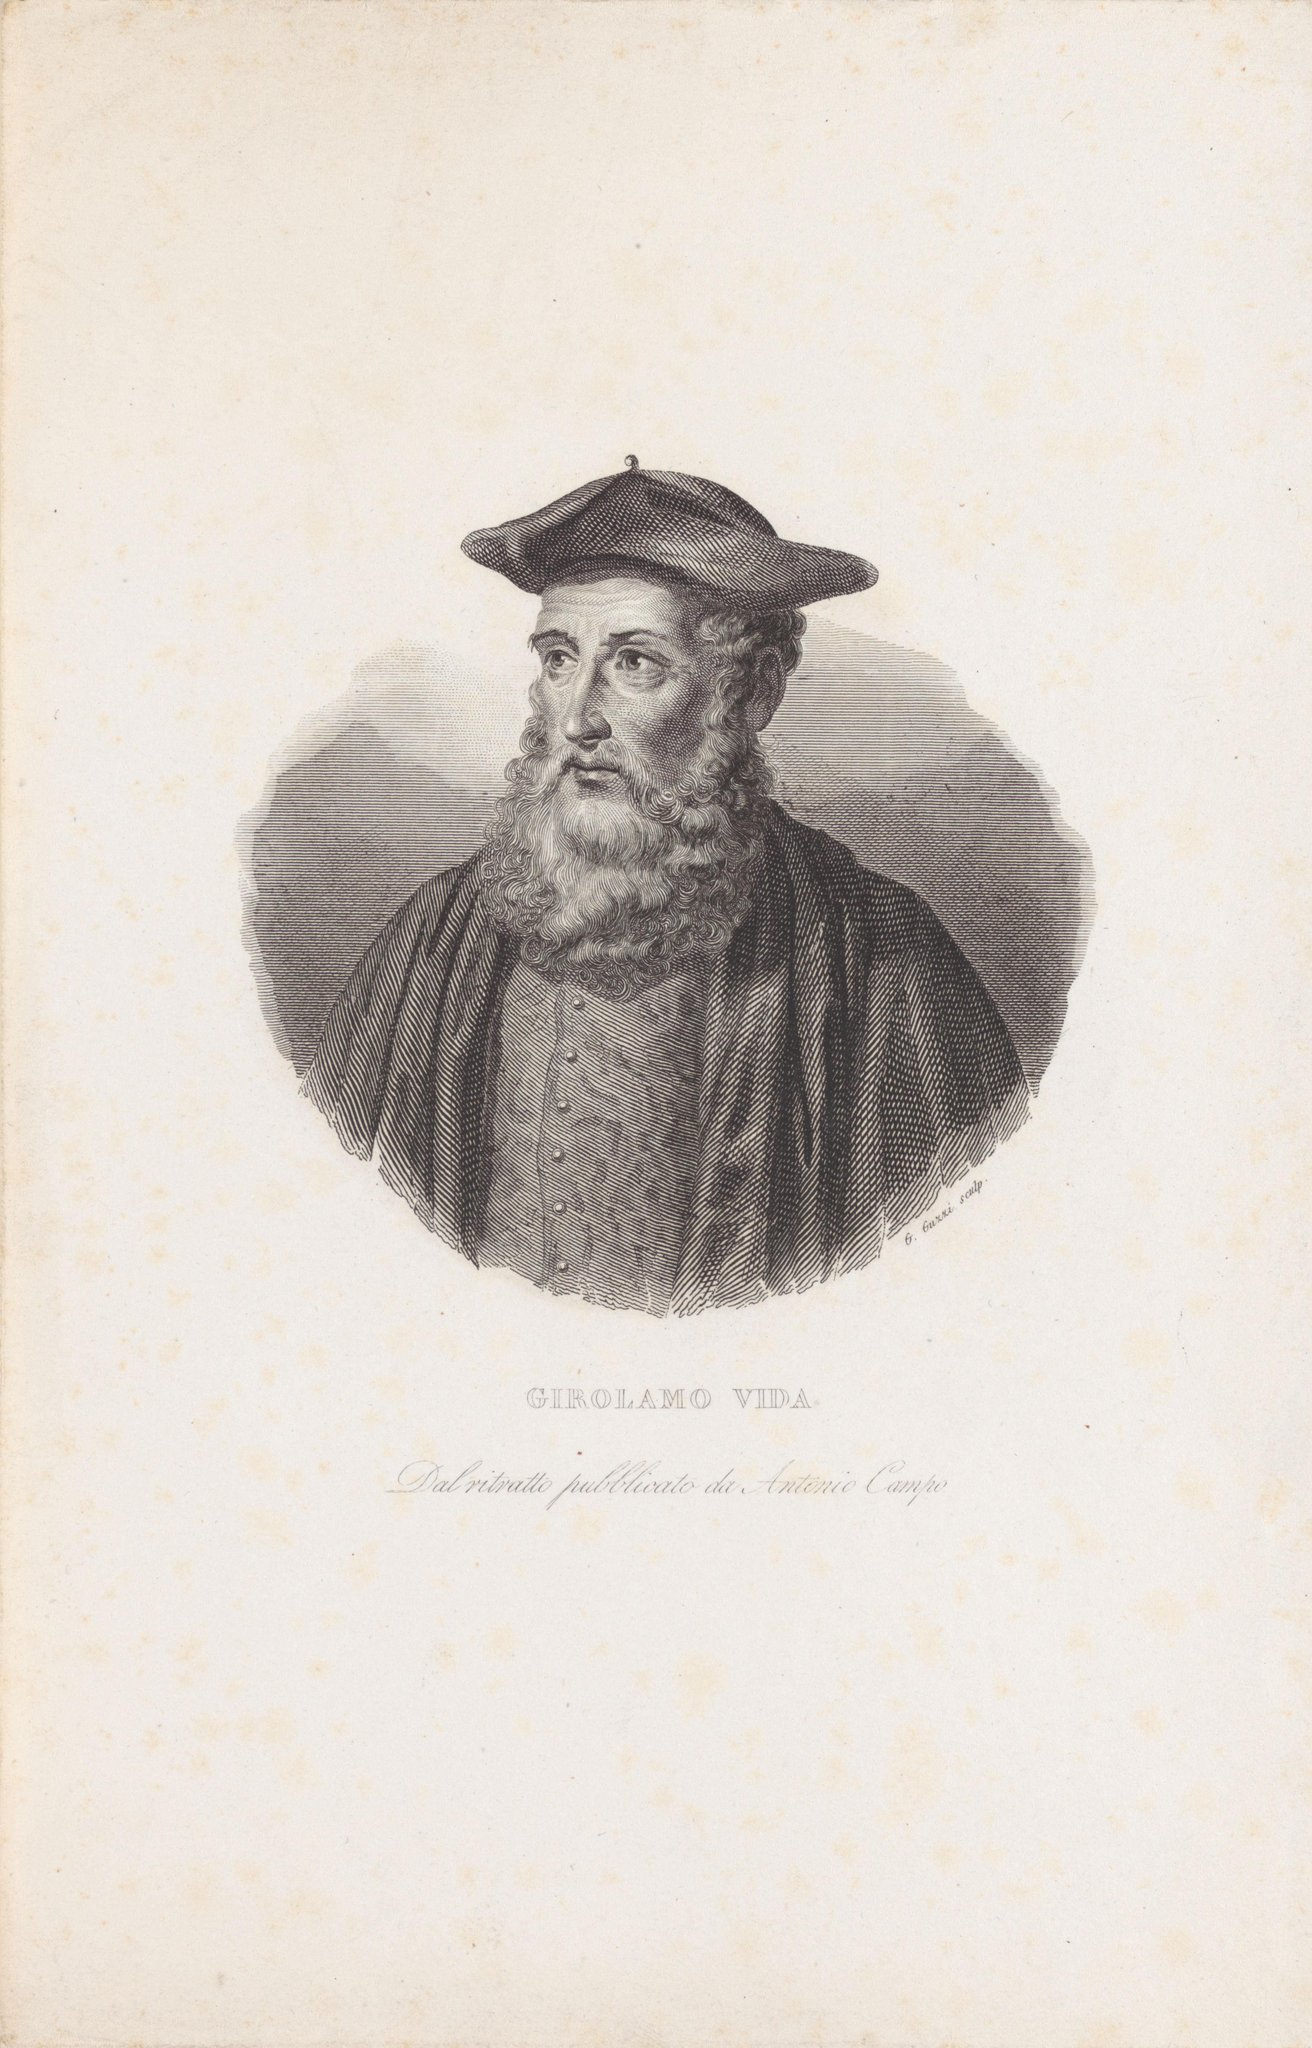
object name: print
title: Portret van humanist Marco Girolamo Vida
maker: giuseppe guzzi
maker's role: print maker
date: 1834-1842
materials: paper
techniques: engraving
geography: italy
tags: historical persons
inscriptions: collector's mark: Lugt 2228